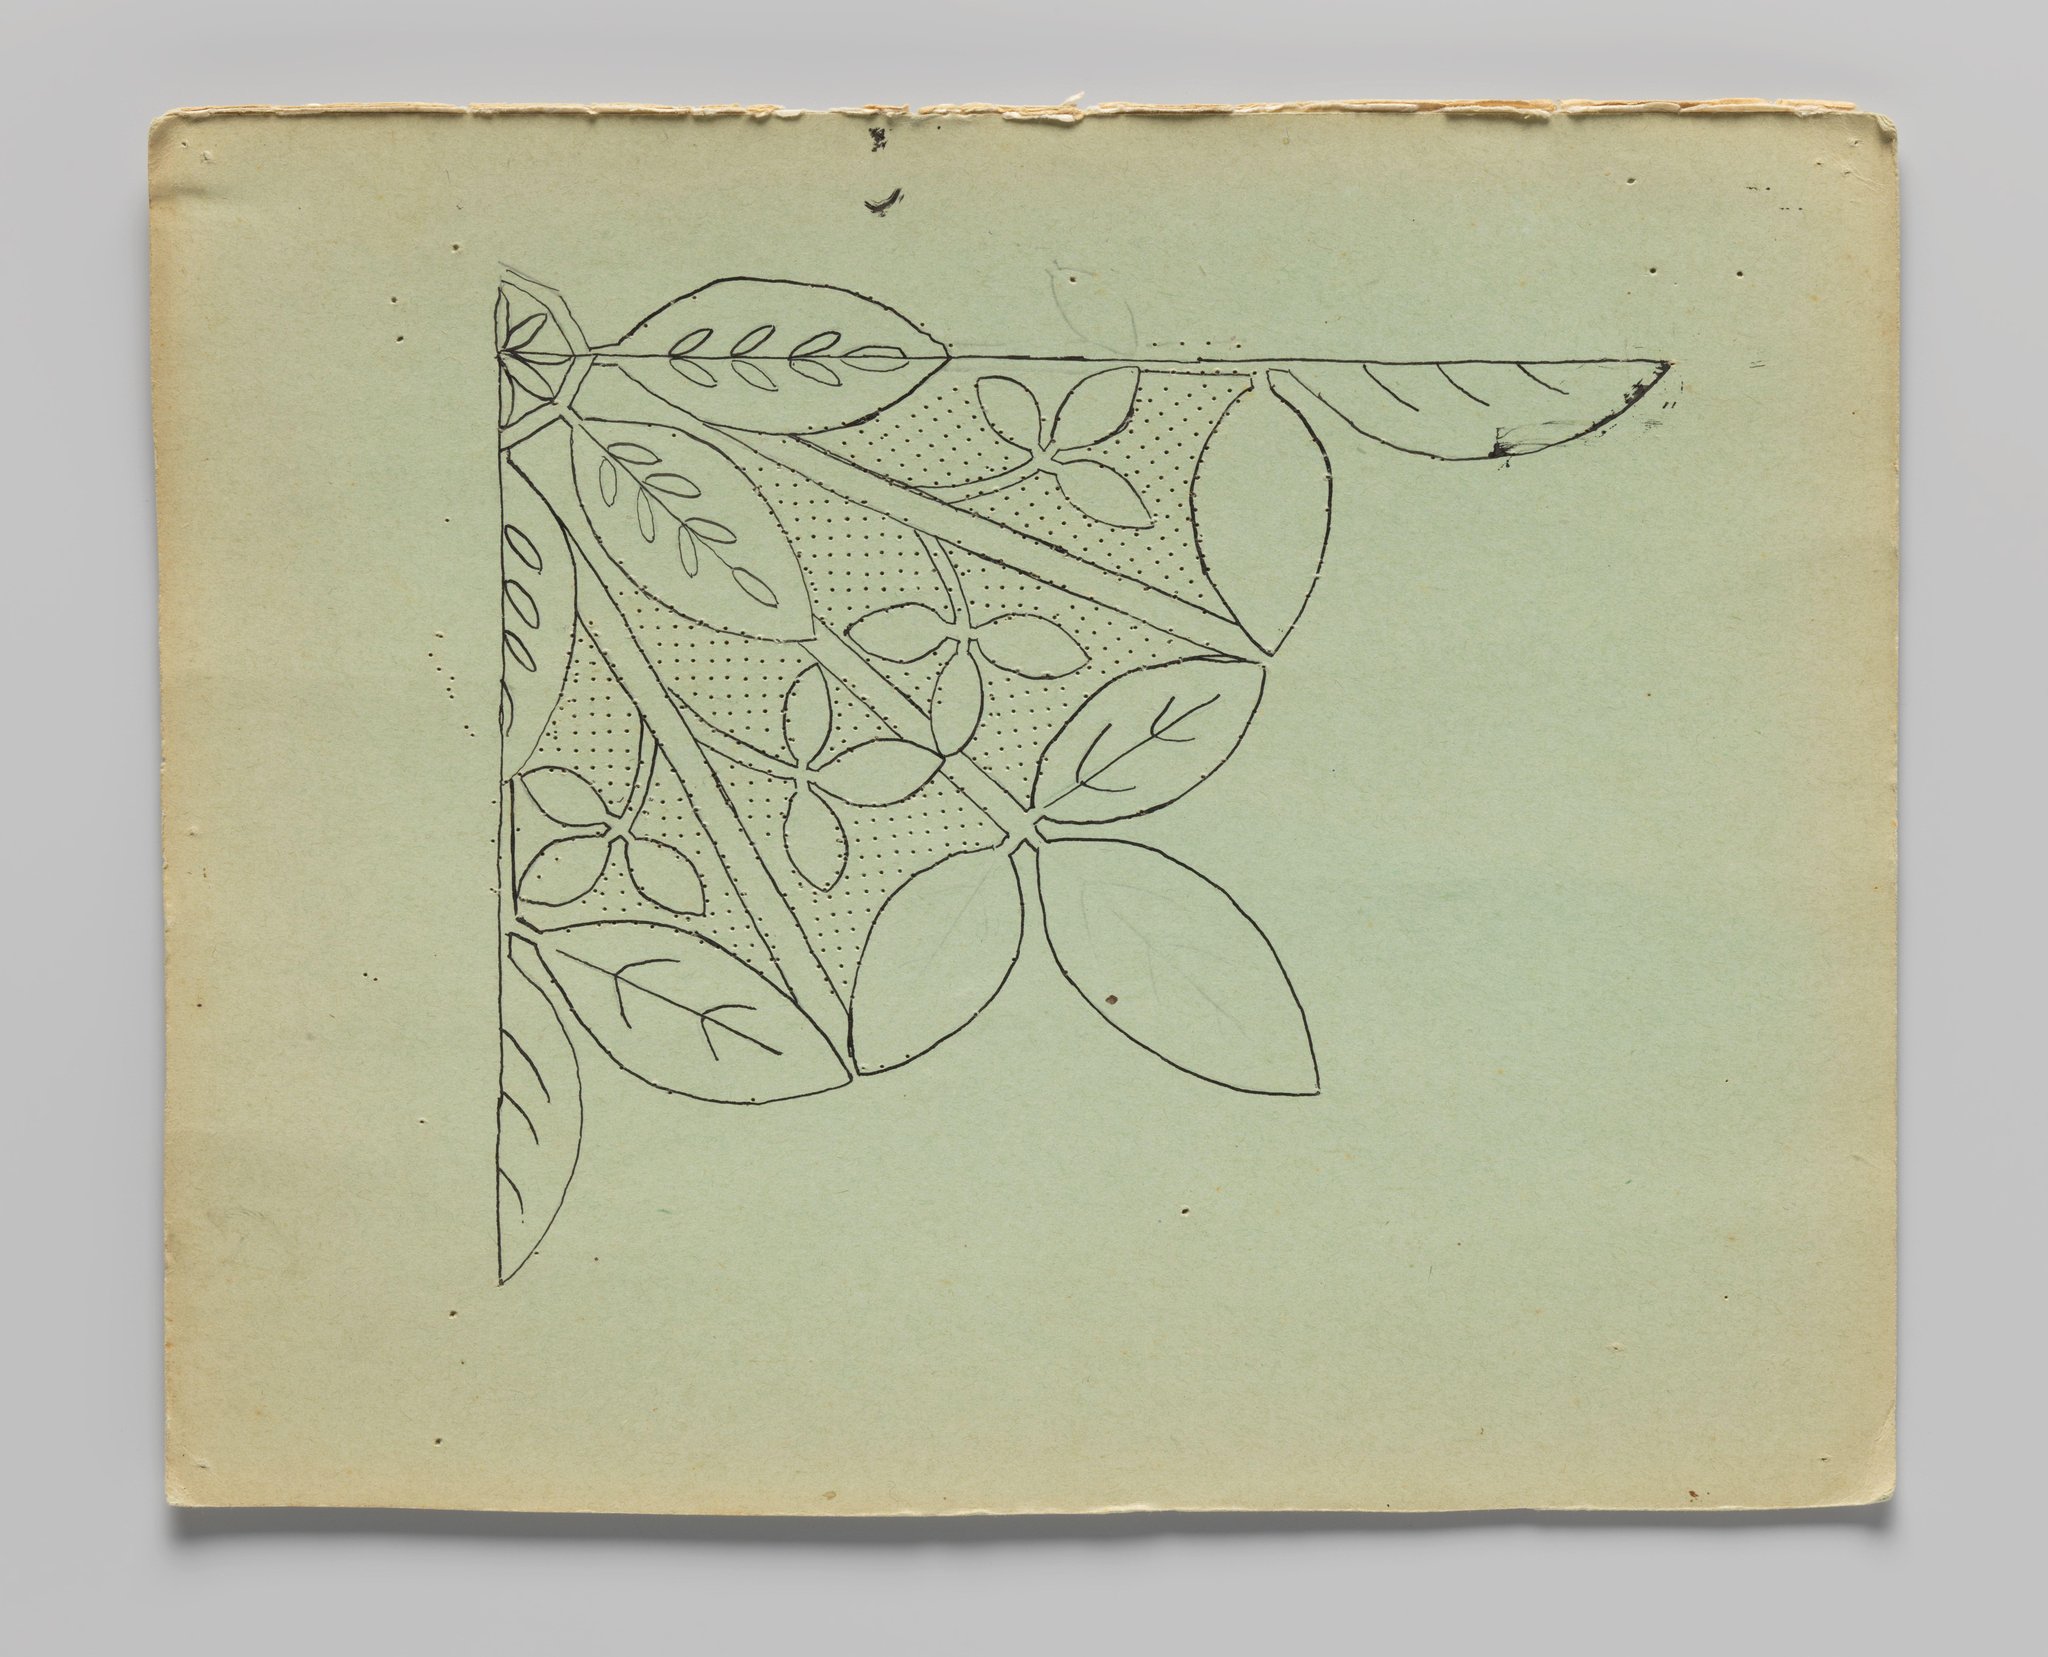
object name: lace pattern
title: Kantpatroon voor een kleed van kloskant met goudenregentakken en -bloemen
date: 1912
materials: paper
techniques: drawing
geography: apeldoorn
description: Kantpatroon met een deel van het patroon voor een kleed met invnr. BK-1979-84.